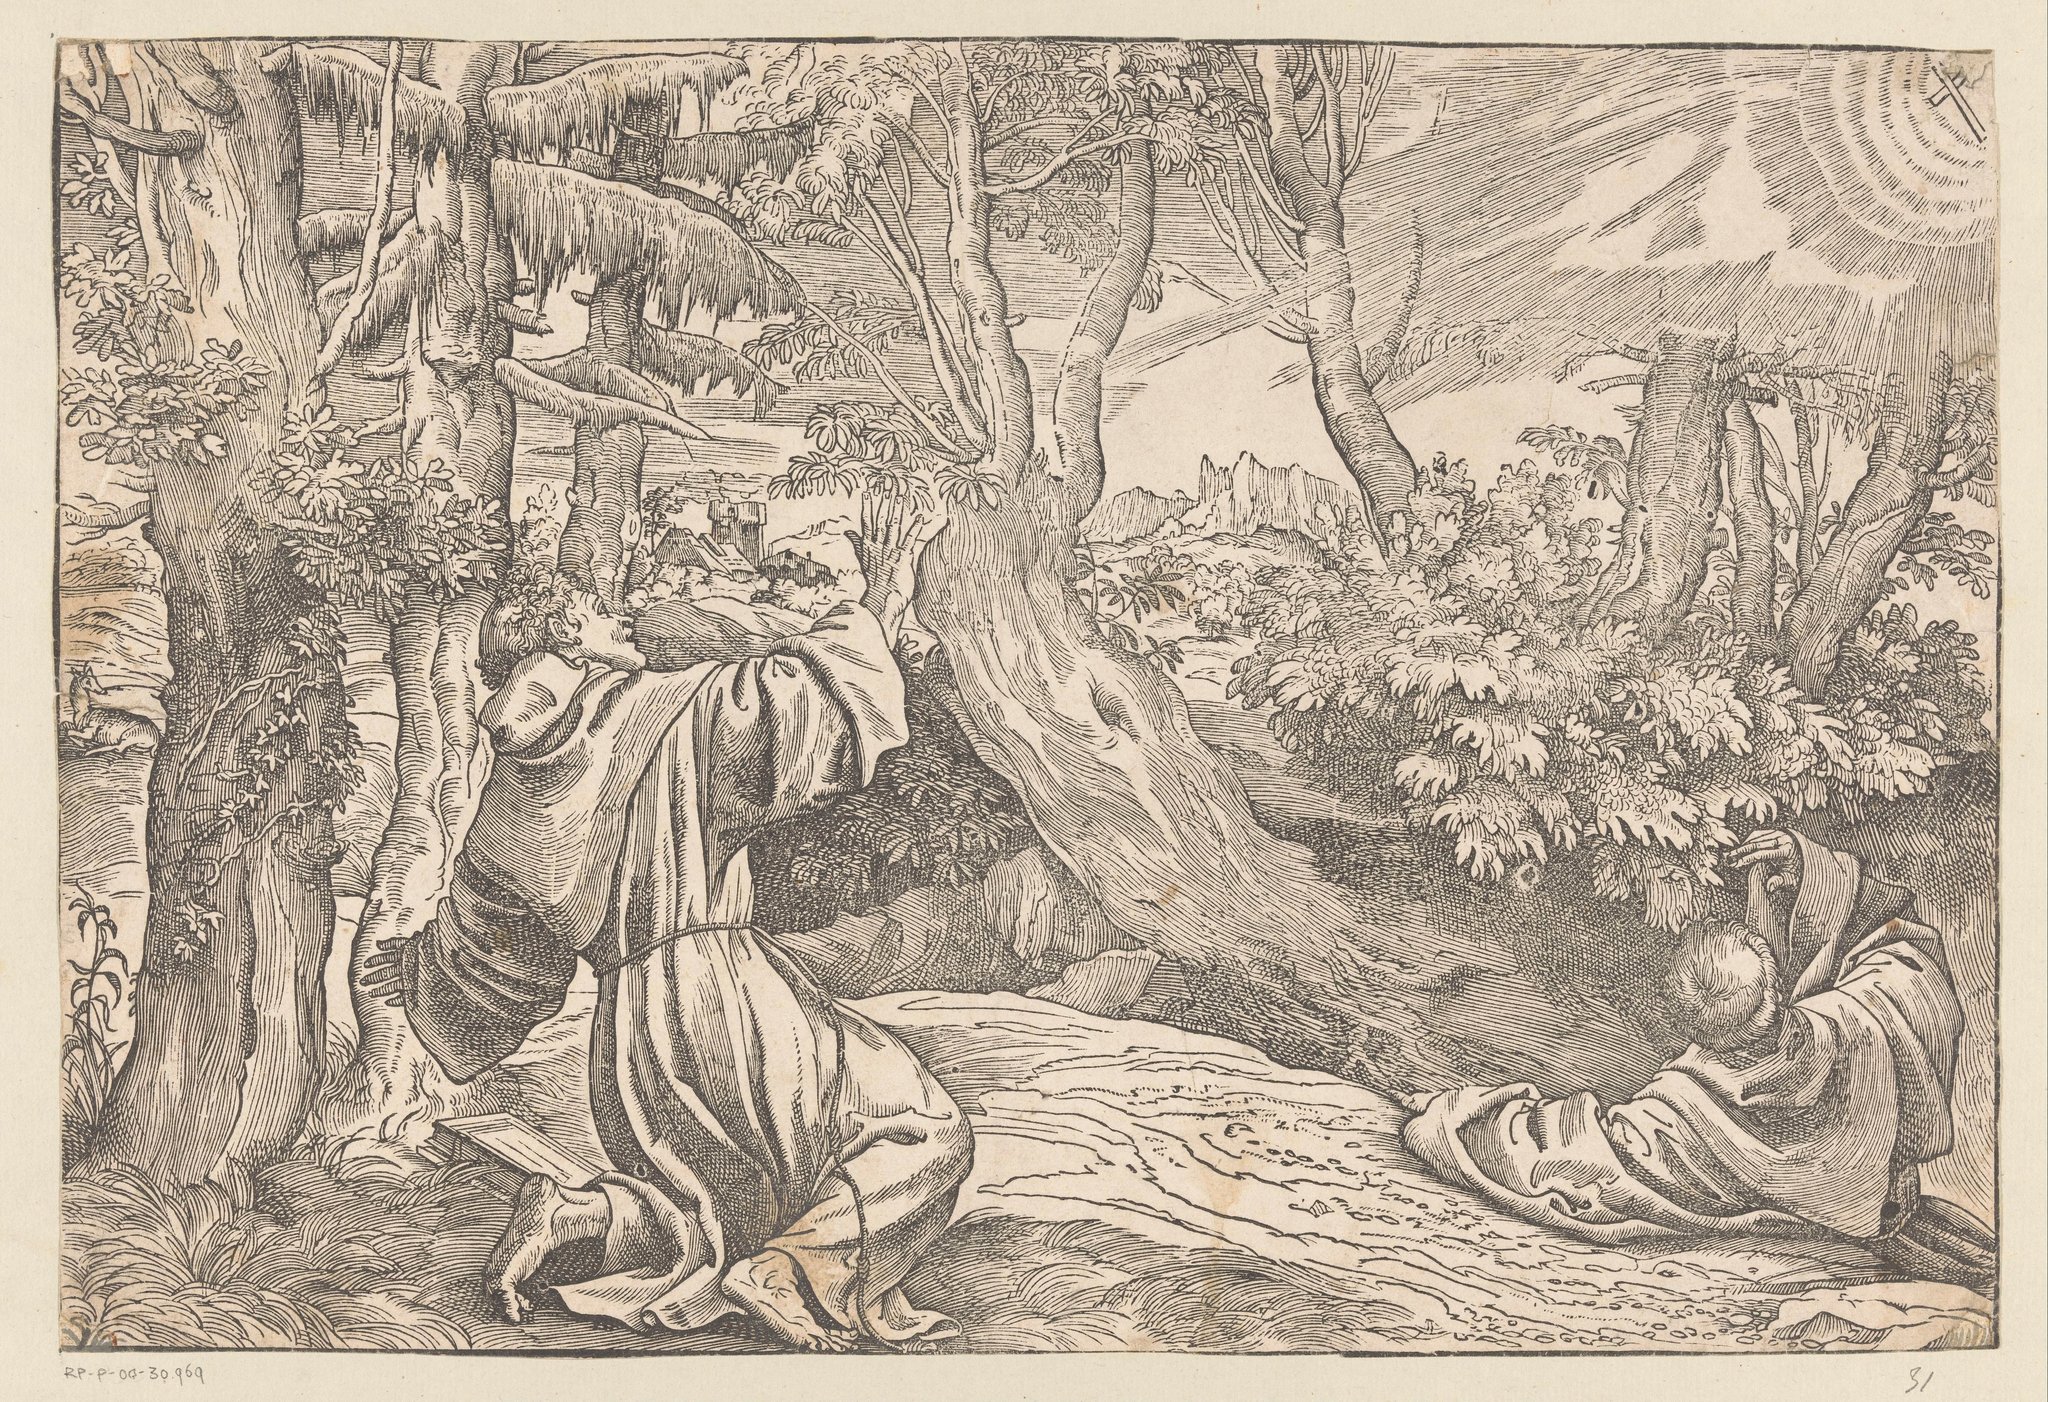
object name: print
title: Heilige Franciscus ontvangt de stigmata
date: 1530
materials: paper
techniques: woodcut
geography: venice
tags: city-view, and landscape with man-made constructions, stigmatization of st. francis of assisi: in retreat on mount alverna, he beholds a vision of christ on the cross enveloped by wings (like a seraph with six wings); rays passing down to the body of the kneeling saint form the marks of the five wounds of christ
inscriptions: collector's mark: Lugt 240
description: De prent is linksonder en rechtsonder beschadigd en met pen in grijs aangevuld.